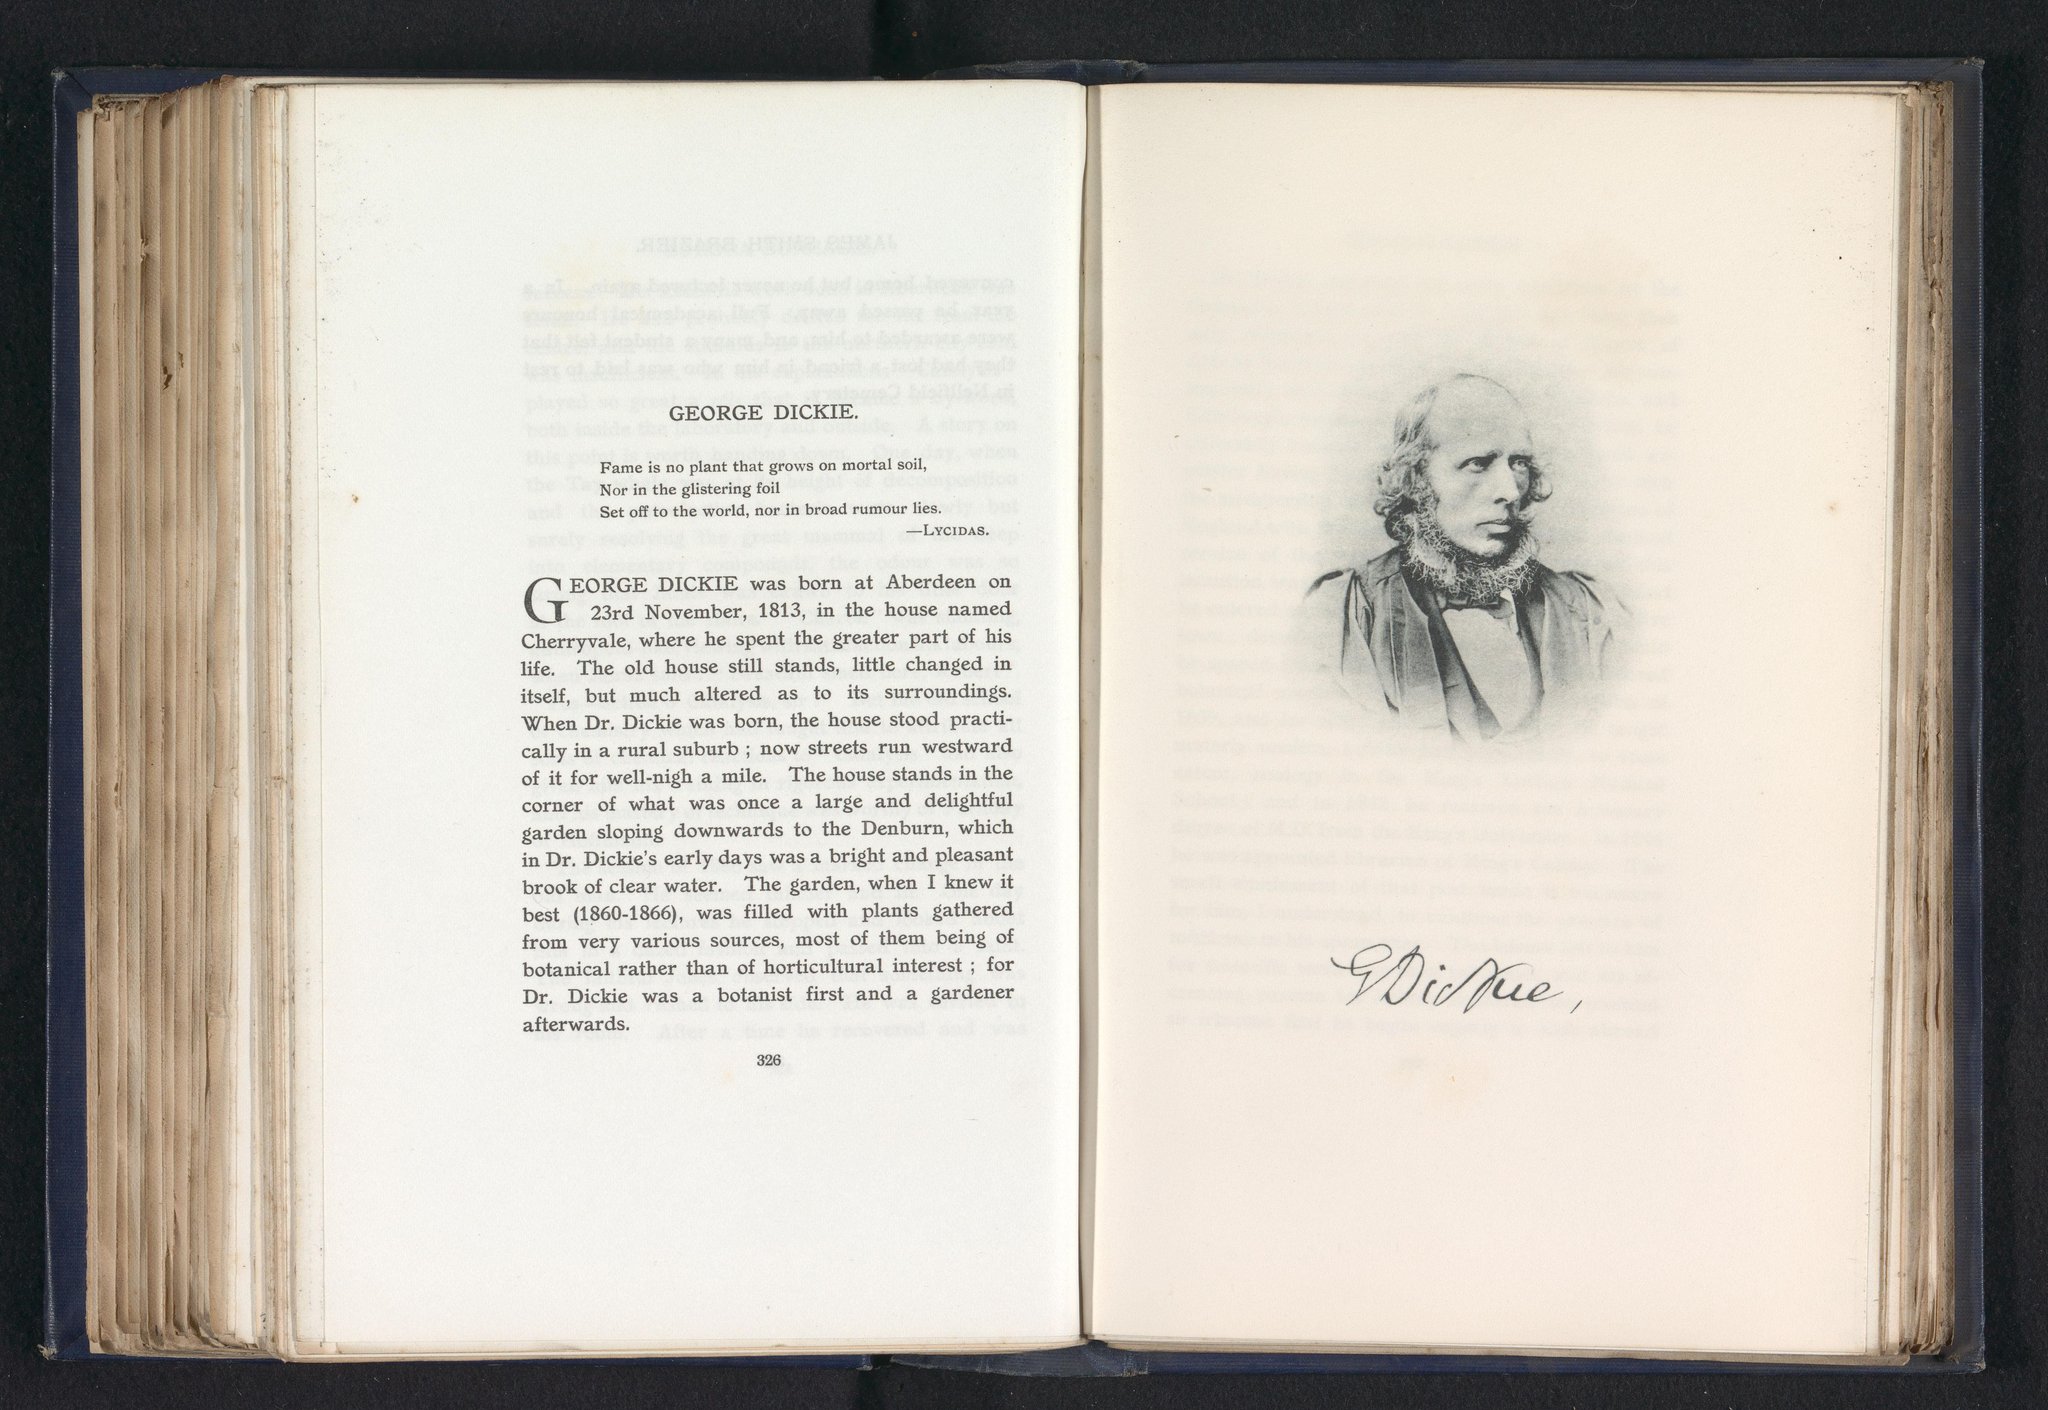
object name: photomechanical print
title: Portret van George Dickie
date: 1872-1882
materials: paper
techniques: photograph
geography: aberdeen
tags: scholar, philosopher